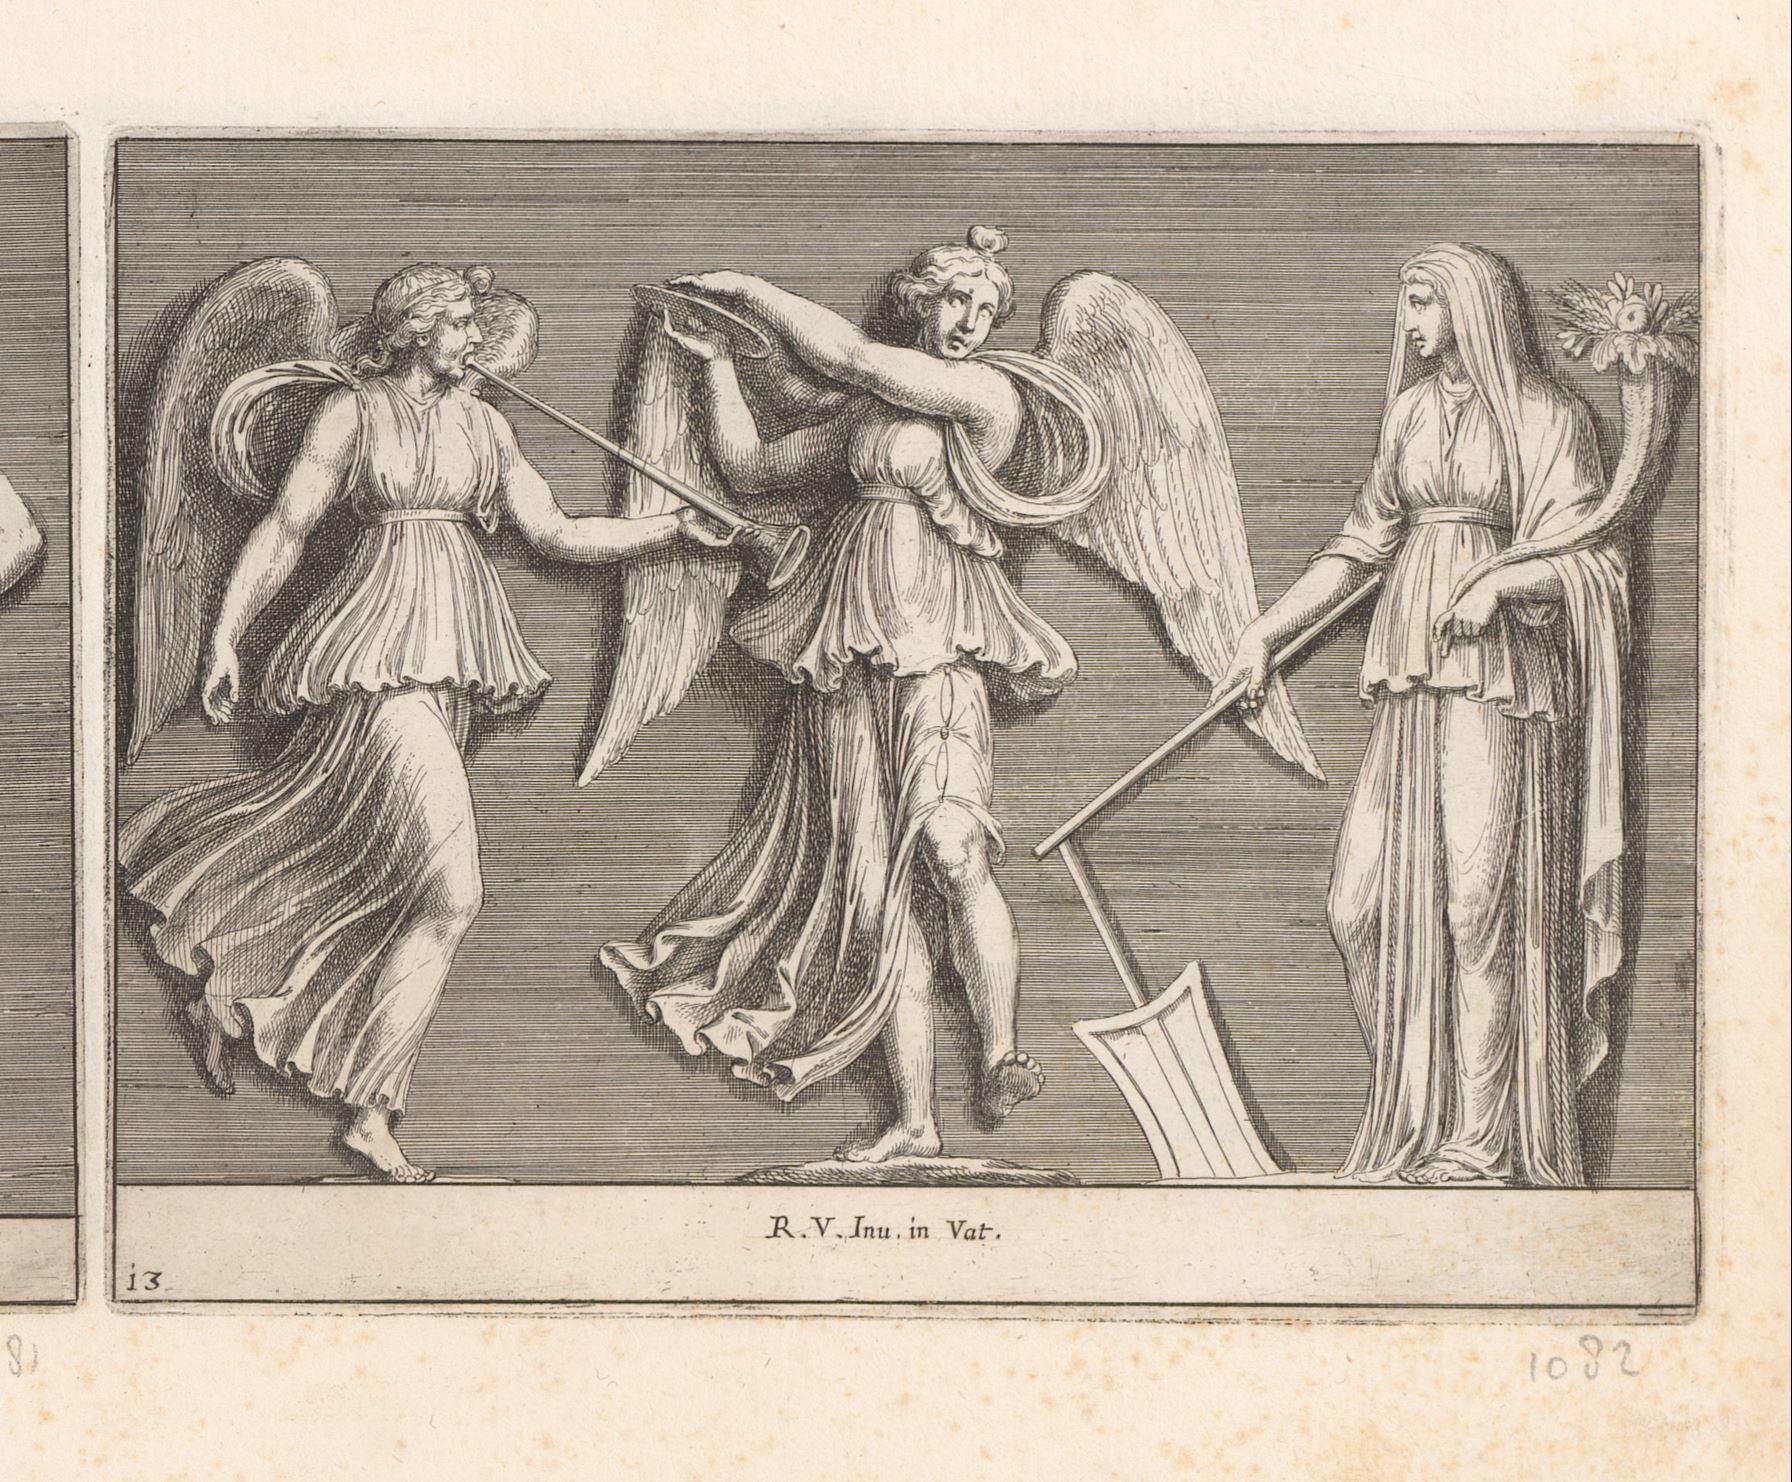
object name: print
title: Reliëfs in de Loggia van Rafaël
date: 1645-1700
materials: paper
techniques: engraving, etching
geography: rome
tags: adult woman, angels singing, making music, angels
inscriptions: number: ‘42’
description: Twee engelen met muziekinstrumenten en een vrouwenfiguur met een hoorn vol vruchten. Prent maakt deel uit van een album.